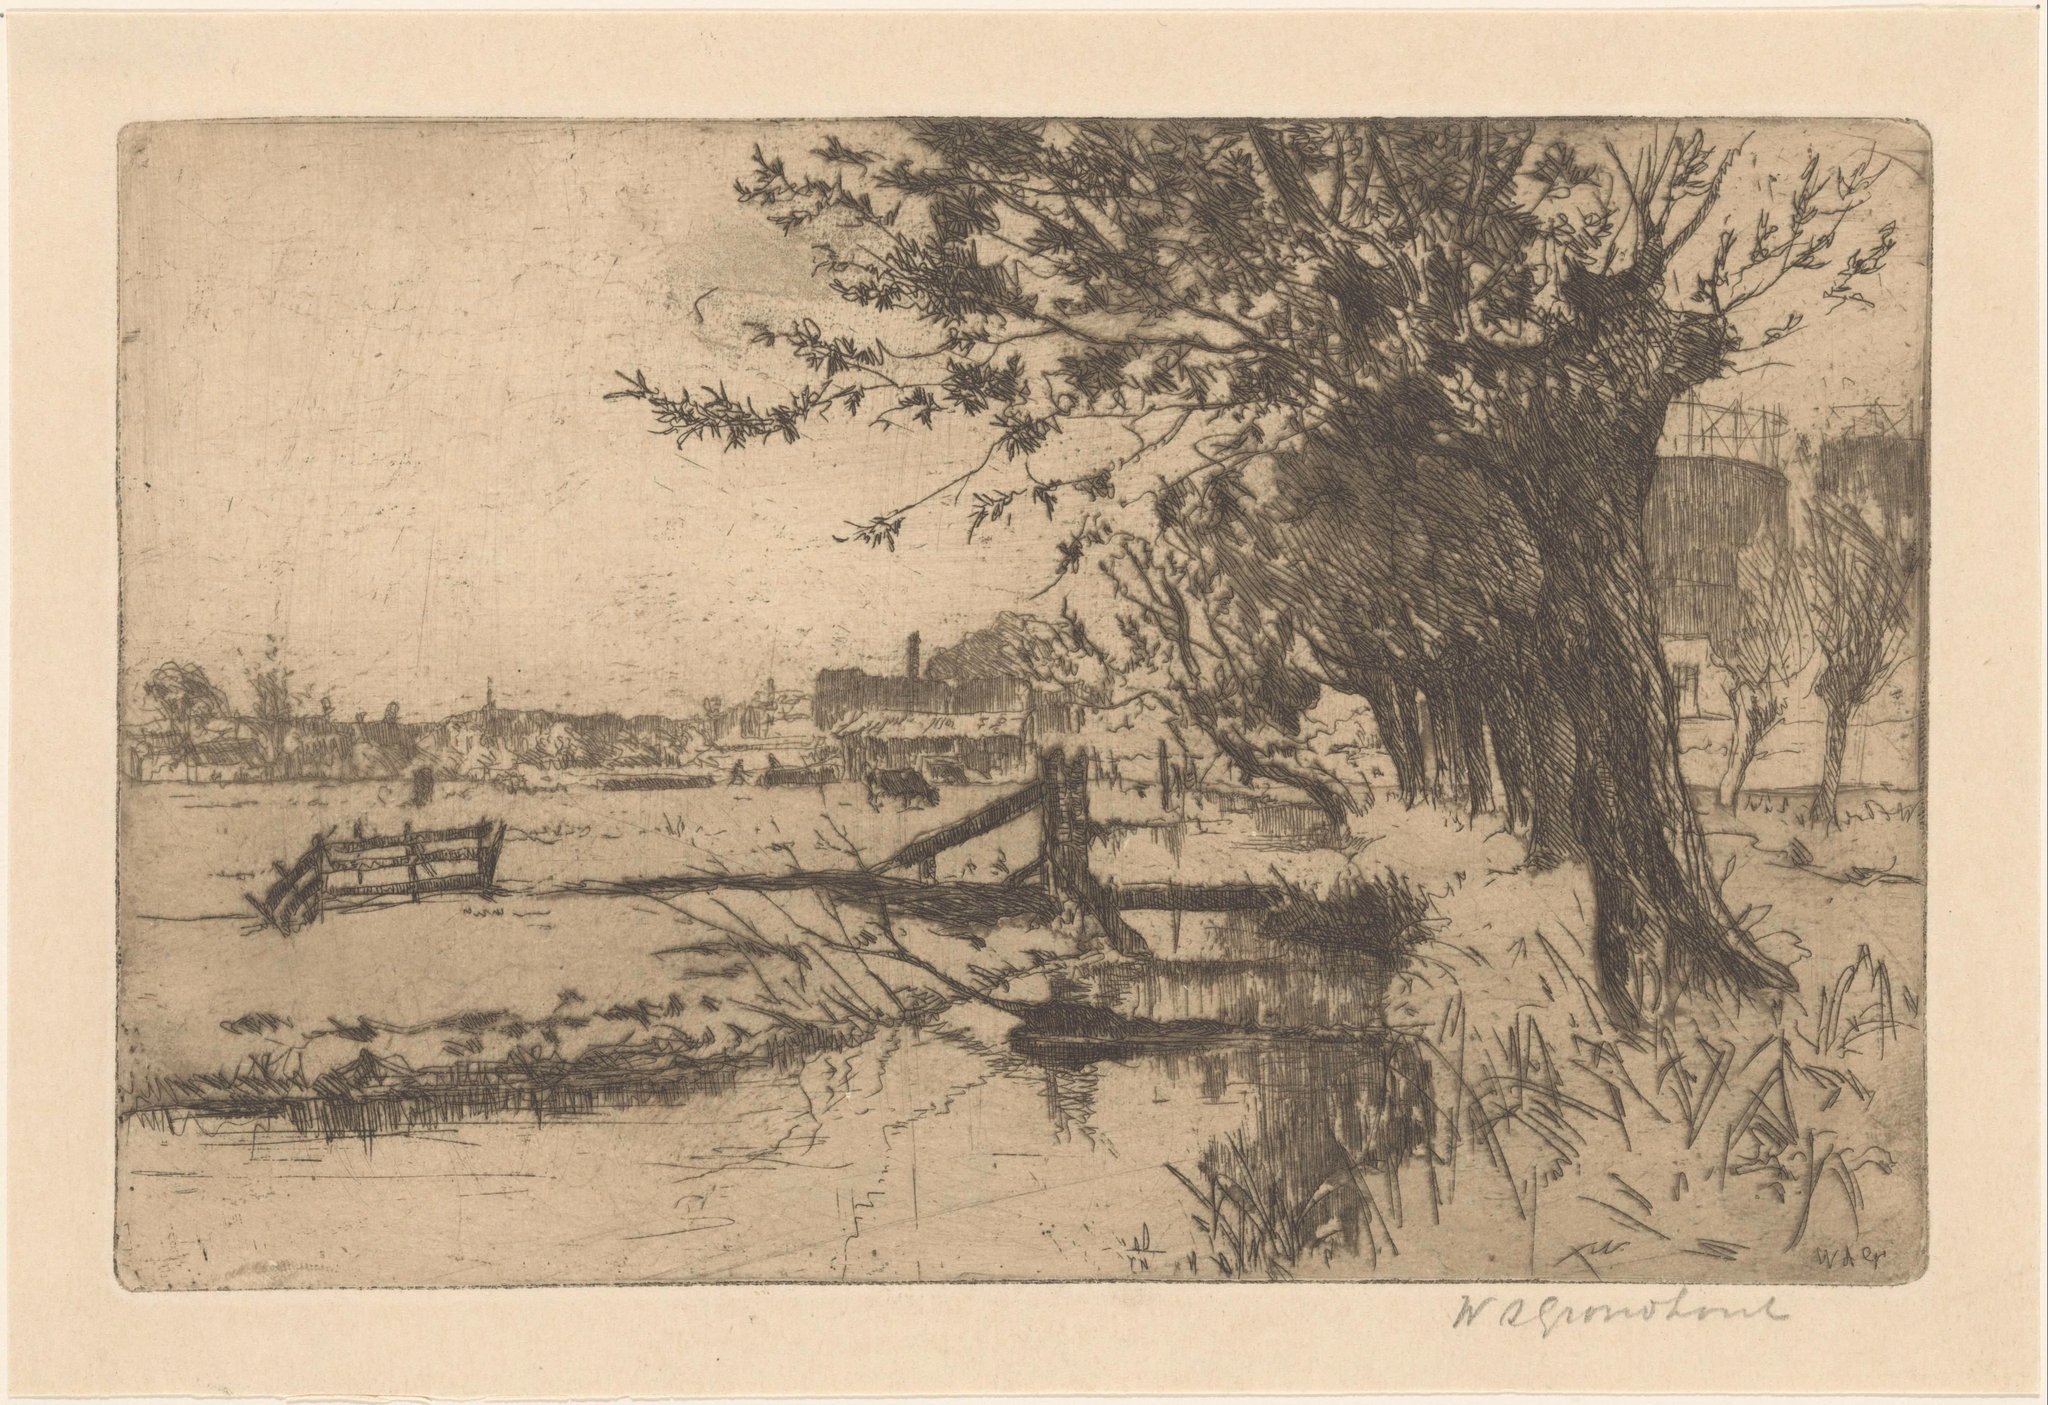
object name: print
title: Sloot bij de Gemeentelijke Gasfabriek in de Binckhorst in Den Haag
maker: willem adrianus grondhout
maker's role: draughtsman, painter, print maker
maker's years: 1878-1934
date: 1888-1931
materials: paper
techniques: etching, intaglio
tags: gasholder, gas tank, meadow, pasture, small canal, ditch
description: Links een weiland met een grazende koe. Rechts op de achtergrond twee gashouders.